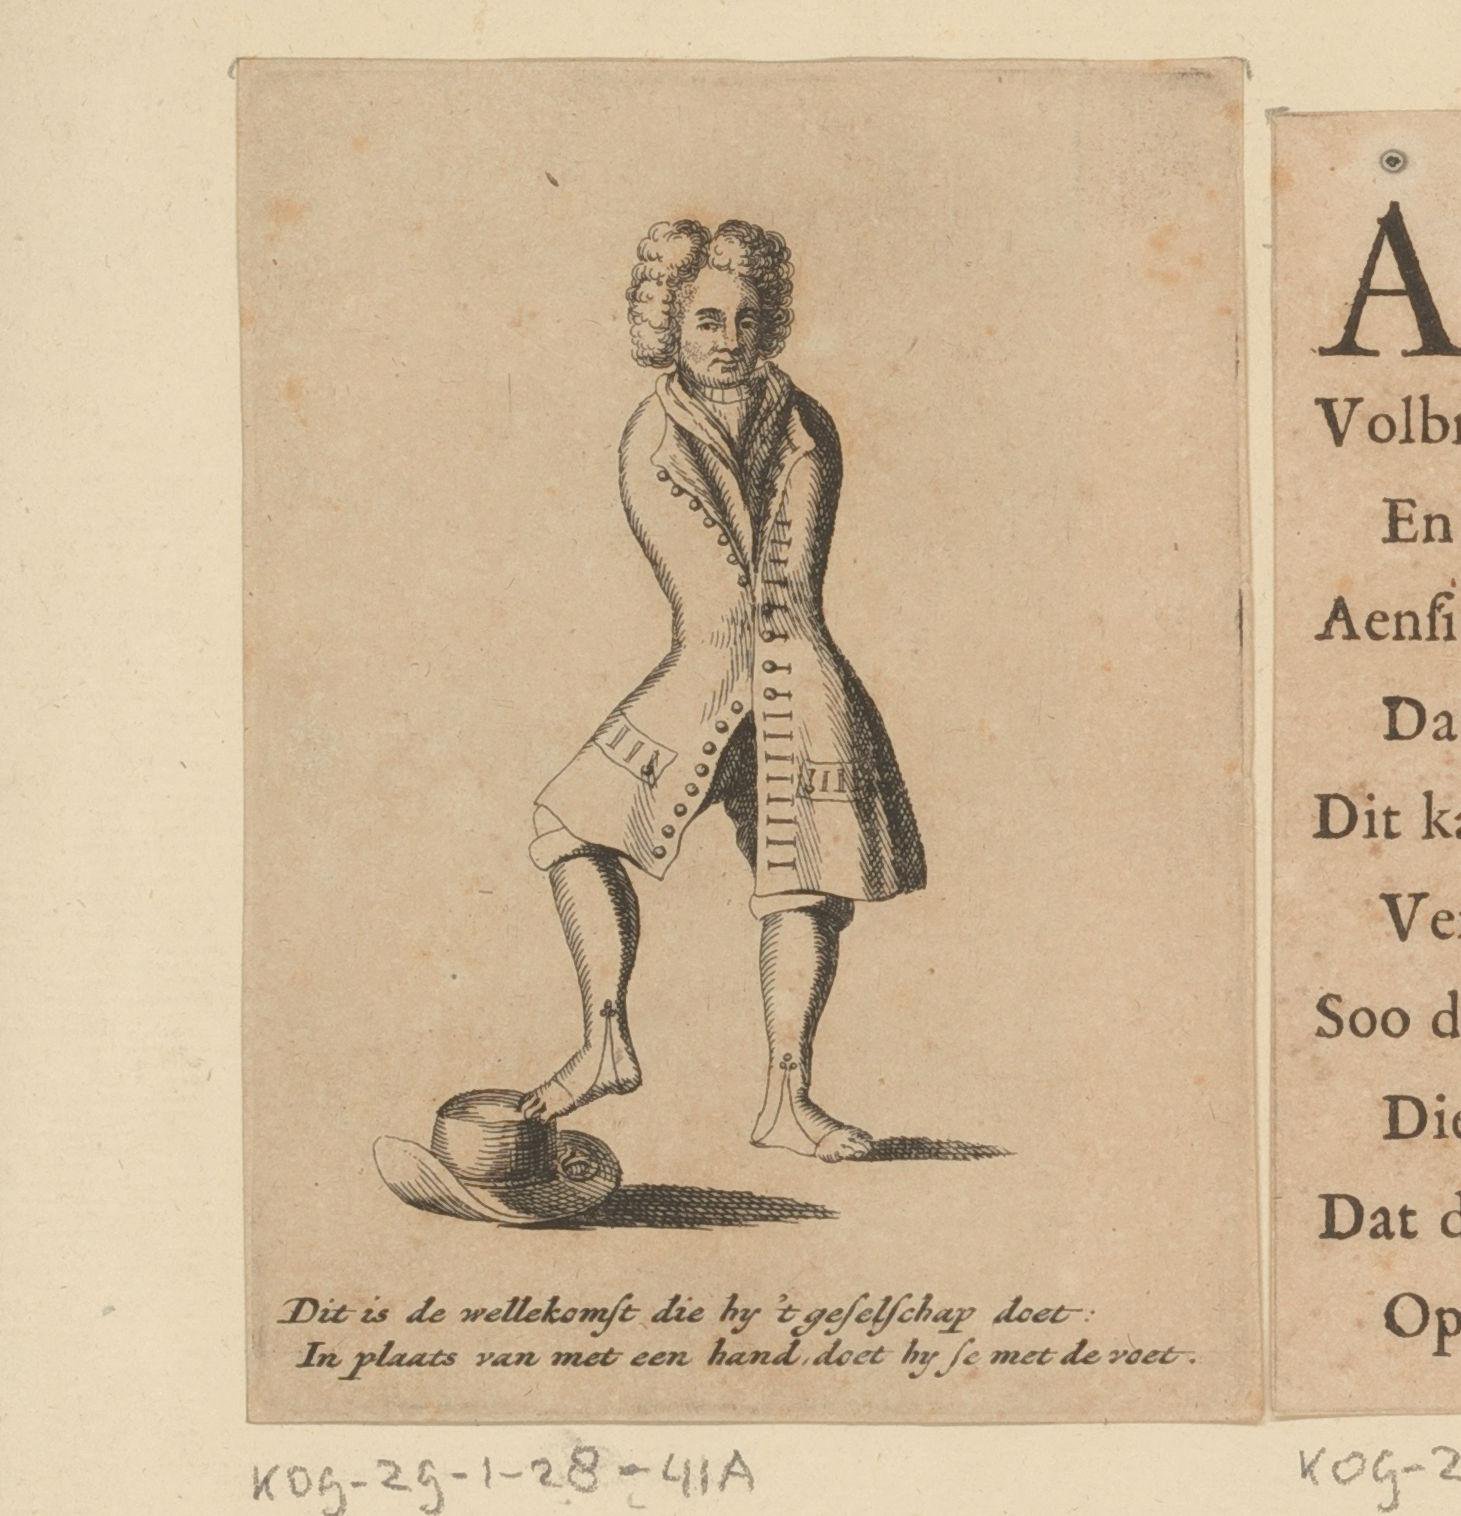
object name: print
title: Valerius, een man zonder armen pakt een hoed vast met zijn tenen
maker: Anonymous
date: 1700-1749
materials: paper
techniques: engraving, etching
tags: head-gear: hat, human monstrosities ~ freak show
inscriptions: stamp, collector's mark: Lugt 1641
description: Onder de voorstelling een tweeregelig vers. Onderwerpsrubrieken binnen de Atlas Zeden en Gewoonten: Zeden en Gewoonten in Engeren Zin. Volksleven. Volksfeesten. Kermistypen, wondermenschen en dergelijken.